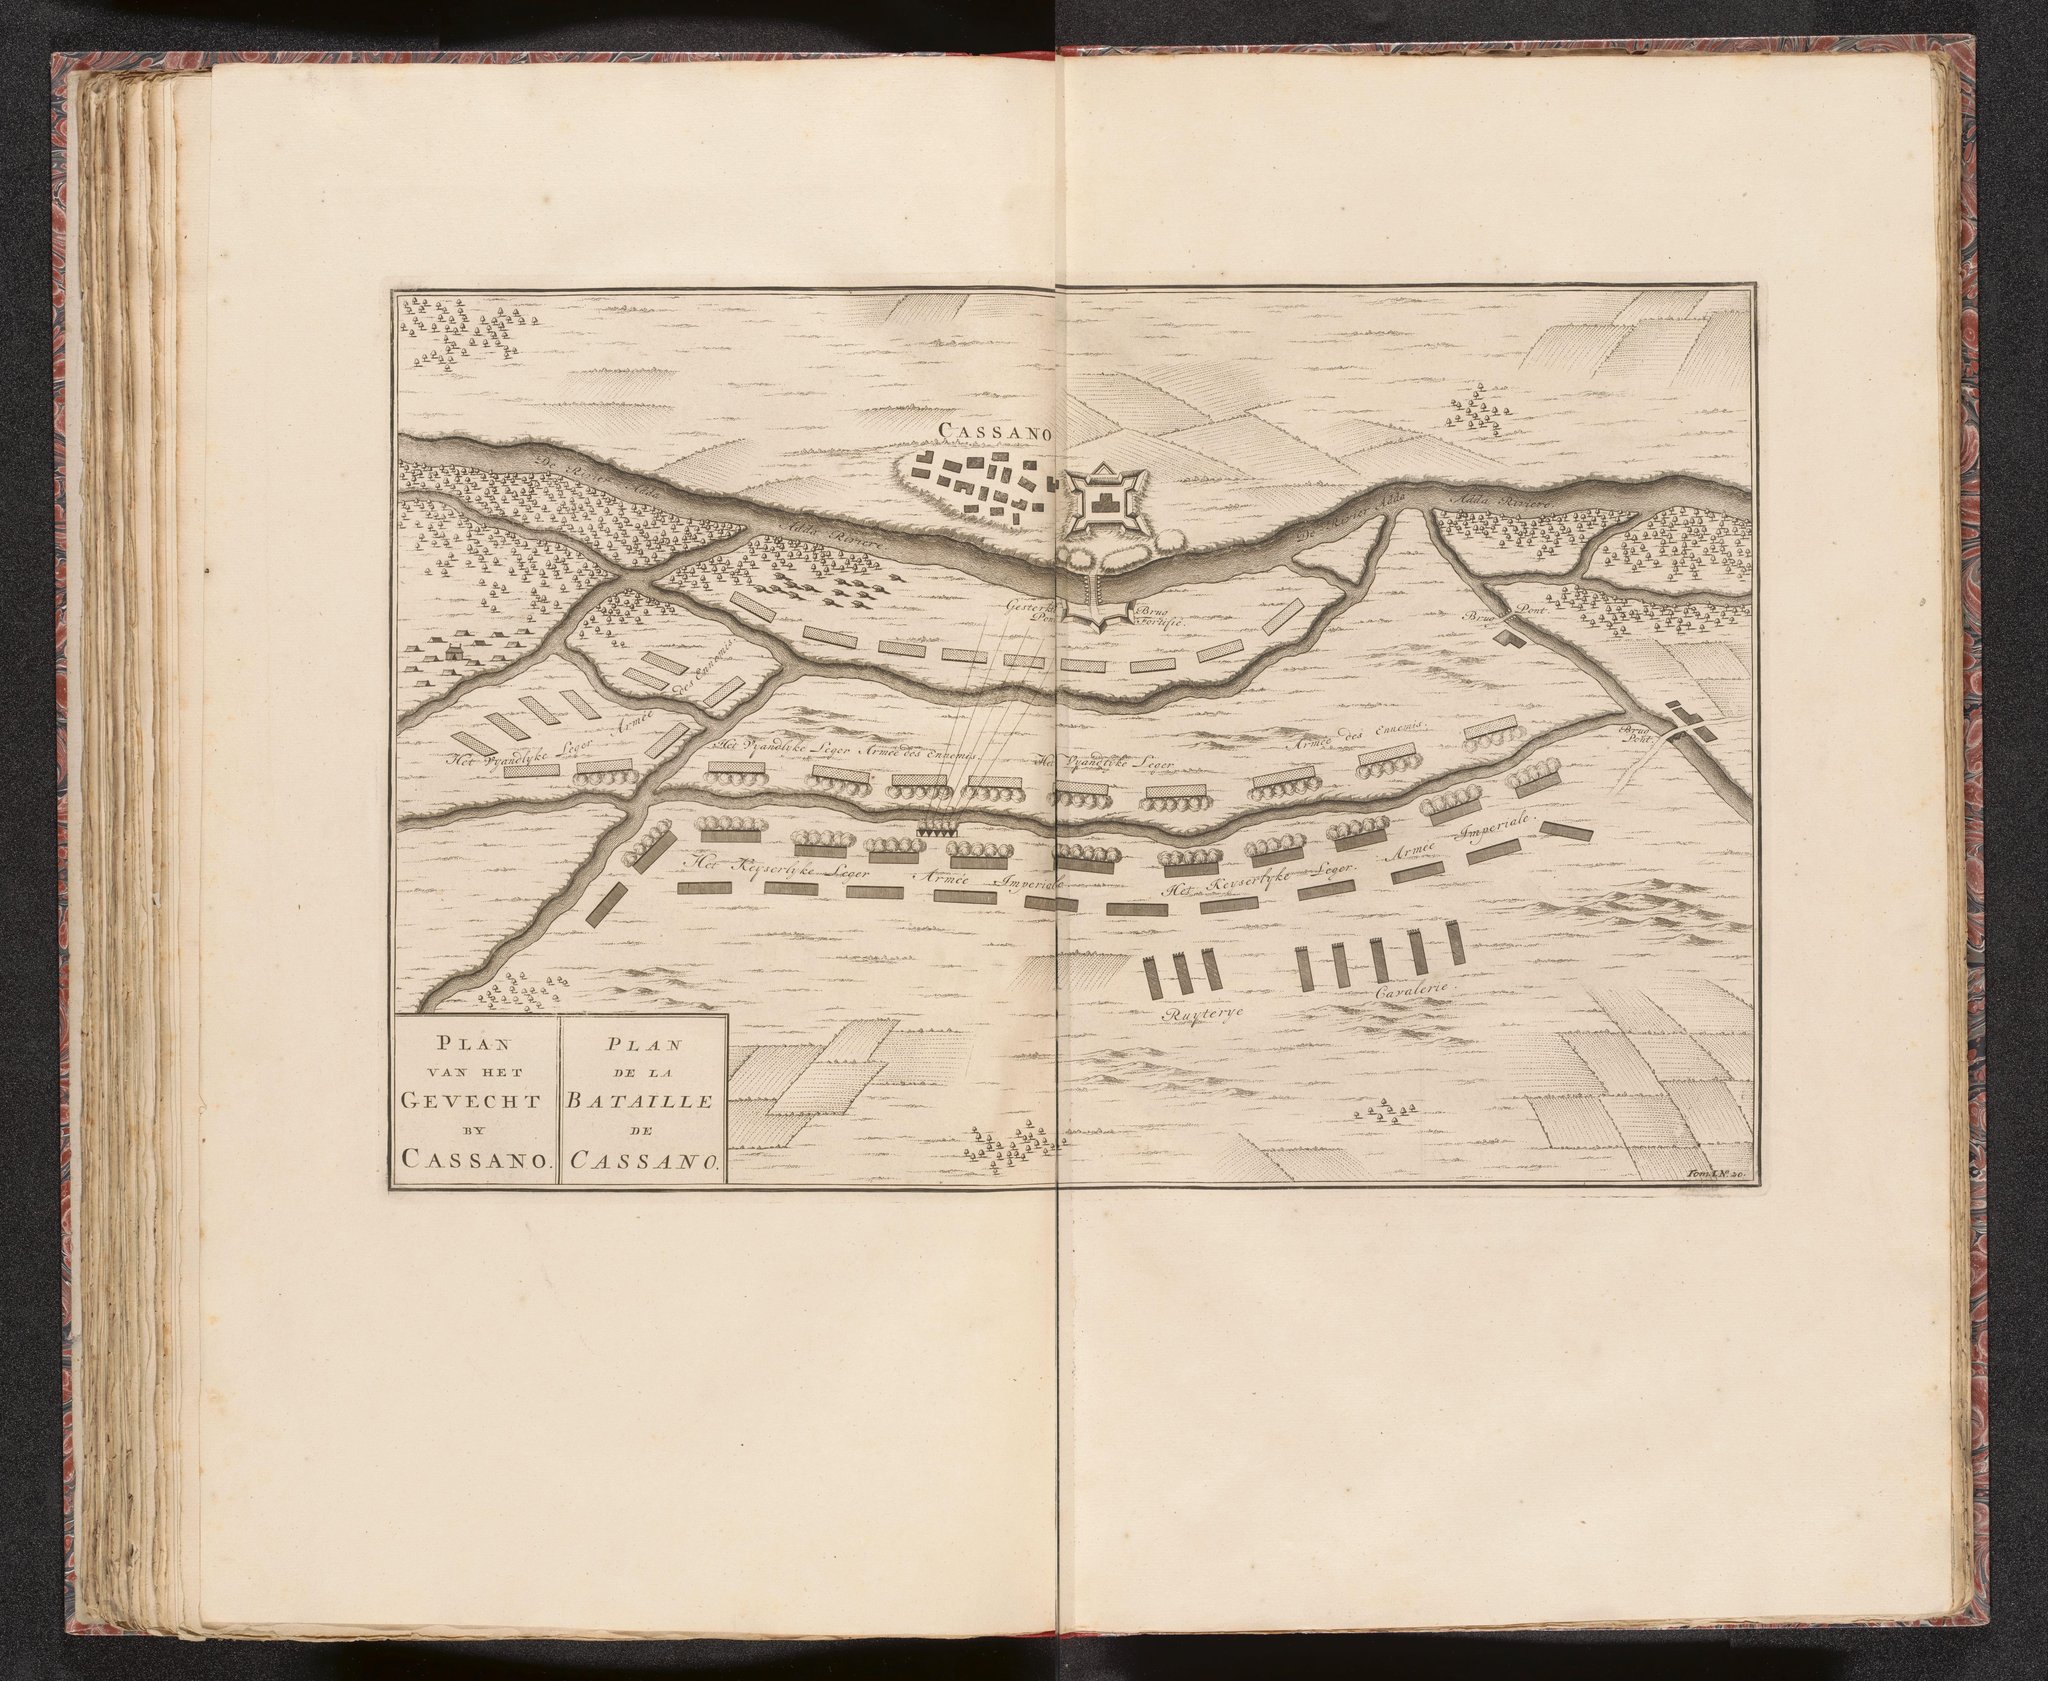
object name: print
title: Plan van het Gevecht by Cassano / Plan de la Bataille de Cassano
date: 1705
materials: paper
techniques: etching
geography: northern netherlands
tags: paris, vienna, eugenius van savoye, maps of separate countries or regions, battle (+ land forces)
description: Kaart van de veldslag bij Cassano d'Adda, tussen de Geallieerden onder de prins van Savoye en de Fransen onder de hertog van Vendome, 16 augustus 1705. Genummerd rechtsonder: Tom. I. No. 20. Illustratie in het eerste deel van: Jean du Mont, Oorlogskundige beschryving van de veldslagen en belegeringen, der drie ... wydvermaarde krygsoversten... den Prins Eugenius van Savoye, den ... Hertog van Marlborough, en den Prins van Oranje en Nassau-Vriesland, in de editie van 1729. Dit eerste deel is gewijd aan de daden van Eugenius, prins van Savoye.